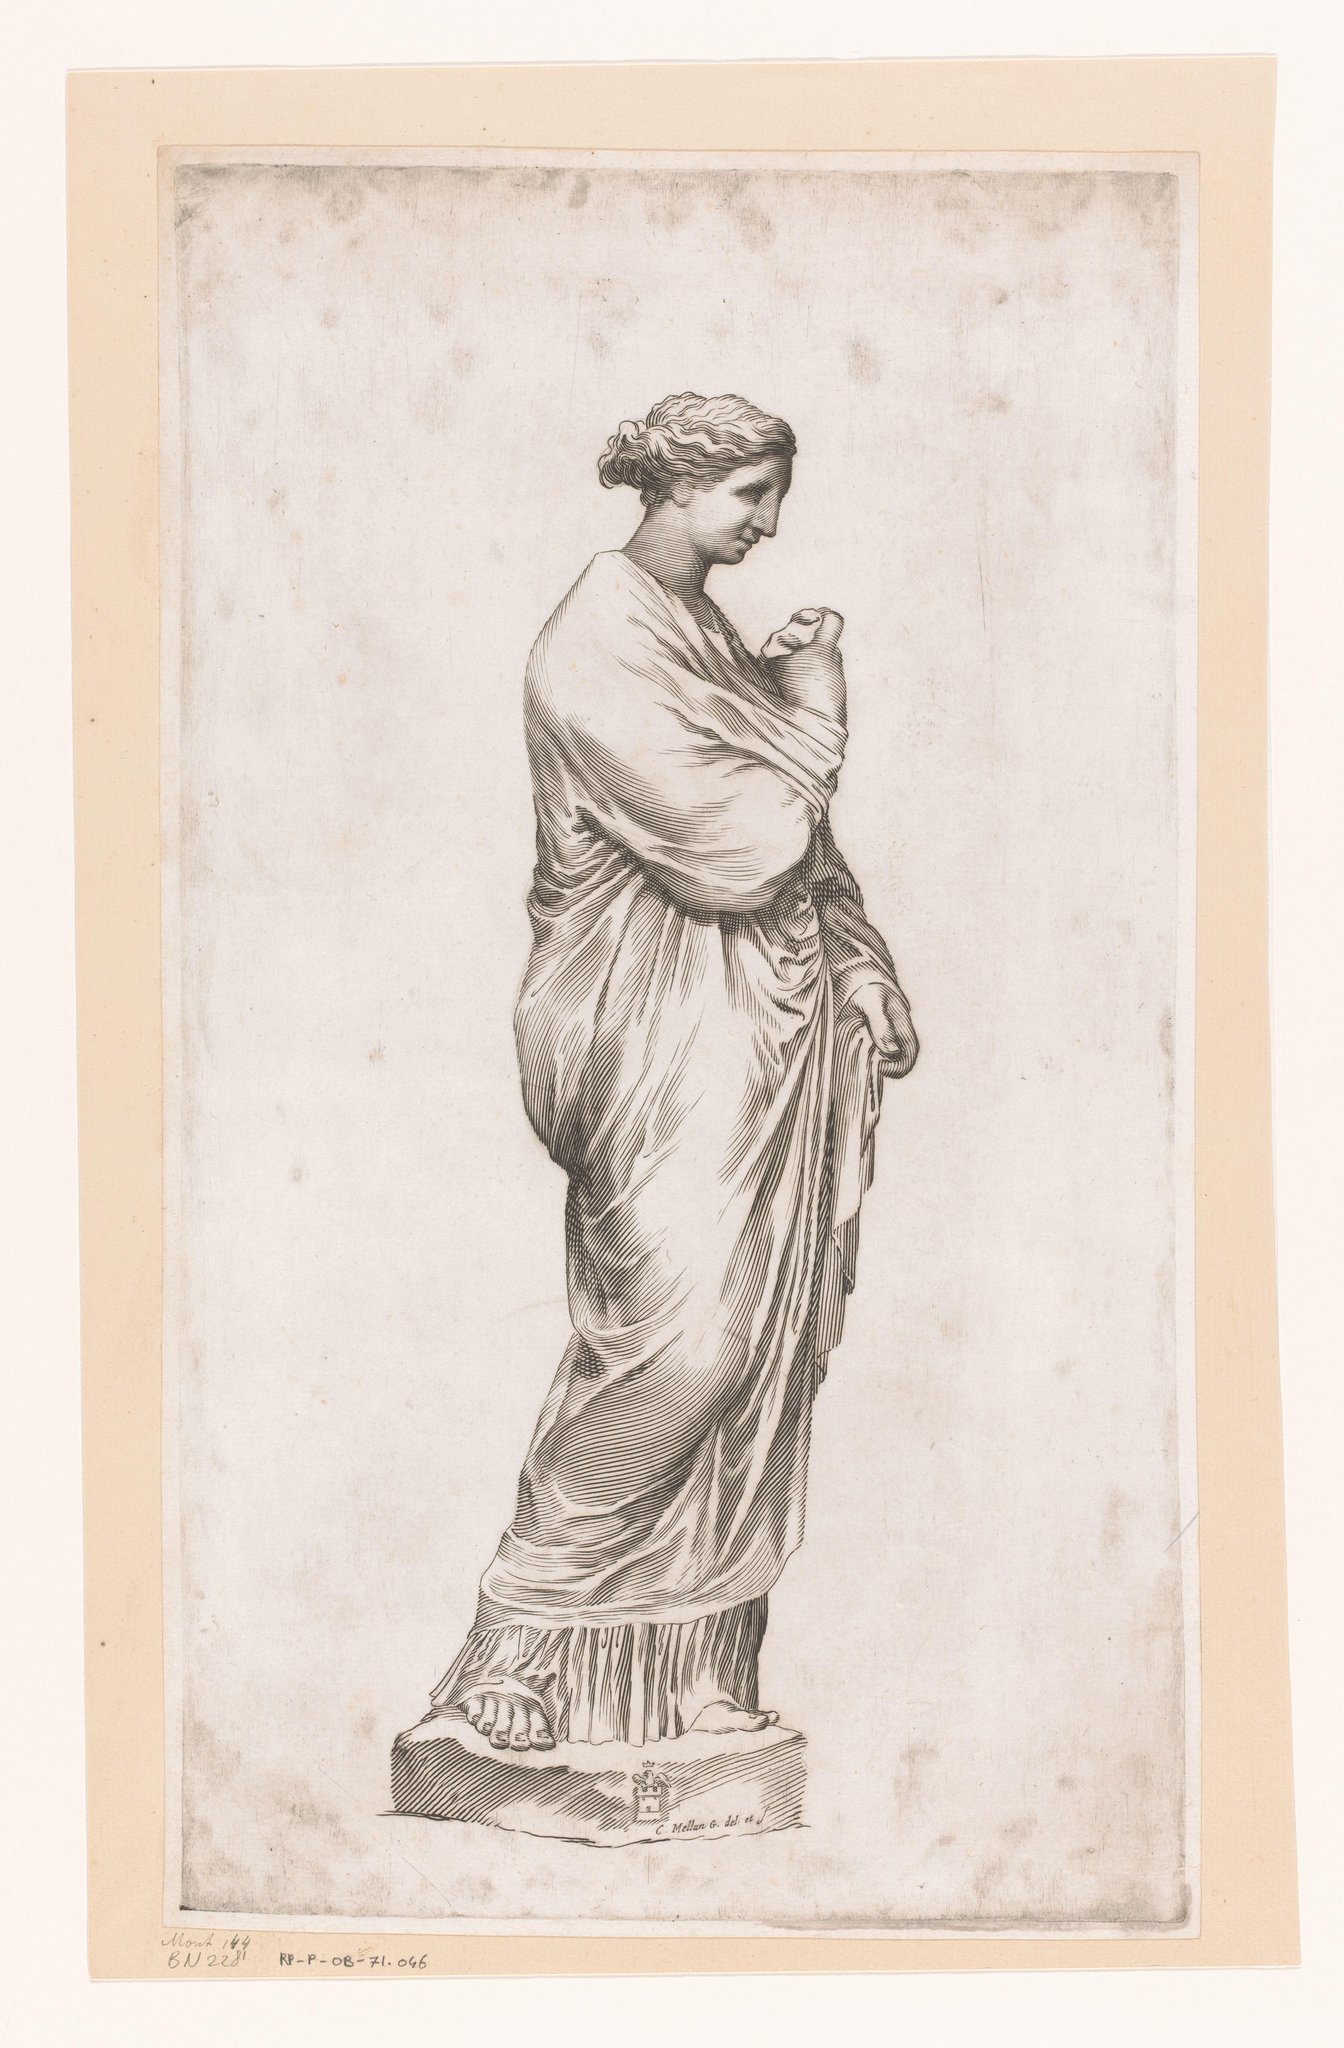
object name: print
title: Standbeeld van staande vrouw in draperie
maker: claude mellan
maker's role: draughtsman, print maker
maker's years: 1598-1688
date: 1631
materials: paper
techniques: engraving, intaglio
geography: rome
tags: rome, vincenzo giustiniani (1564-1637), piece of sculpture, reproduction of a piece of sculpture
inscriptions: collector's mark: Lugt 240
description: Maakt deel uit van een serie bestaande uit 322 prenten van kunstwerken uit de collectie van Vincenzo Giustiniani die in twee volumes werd uitgegeven door Joachim von Sandrart in 1636 en 1637 (zie British Museum, inv.nr. 1851,1213.565). De serie bestaat uit prenten door verschillende kunstenaars zoals Cornelis Bloemaert, Theodore Matham, Pieter de Bailliu en Michel Natalis. Claude Mellan was verantwoordelijk voor 22 prenten van standbeelden en het 1631 gedateerde portret van Giustiniani.